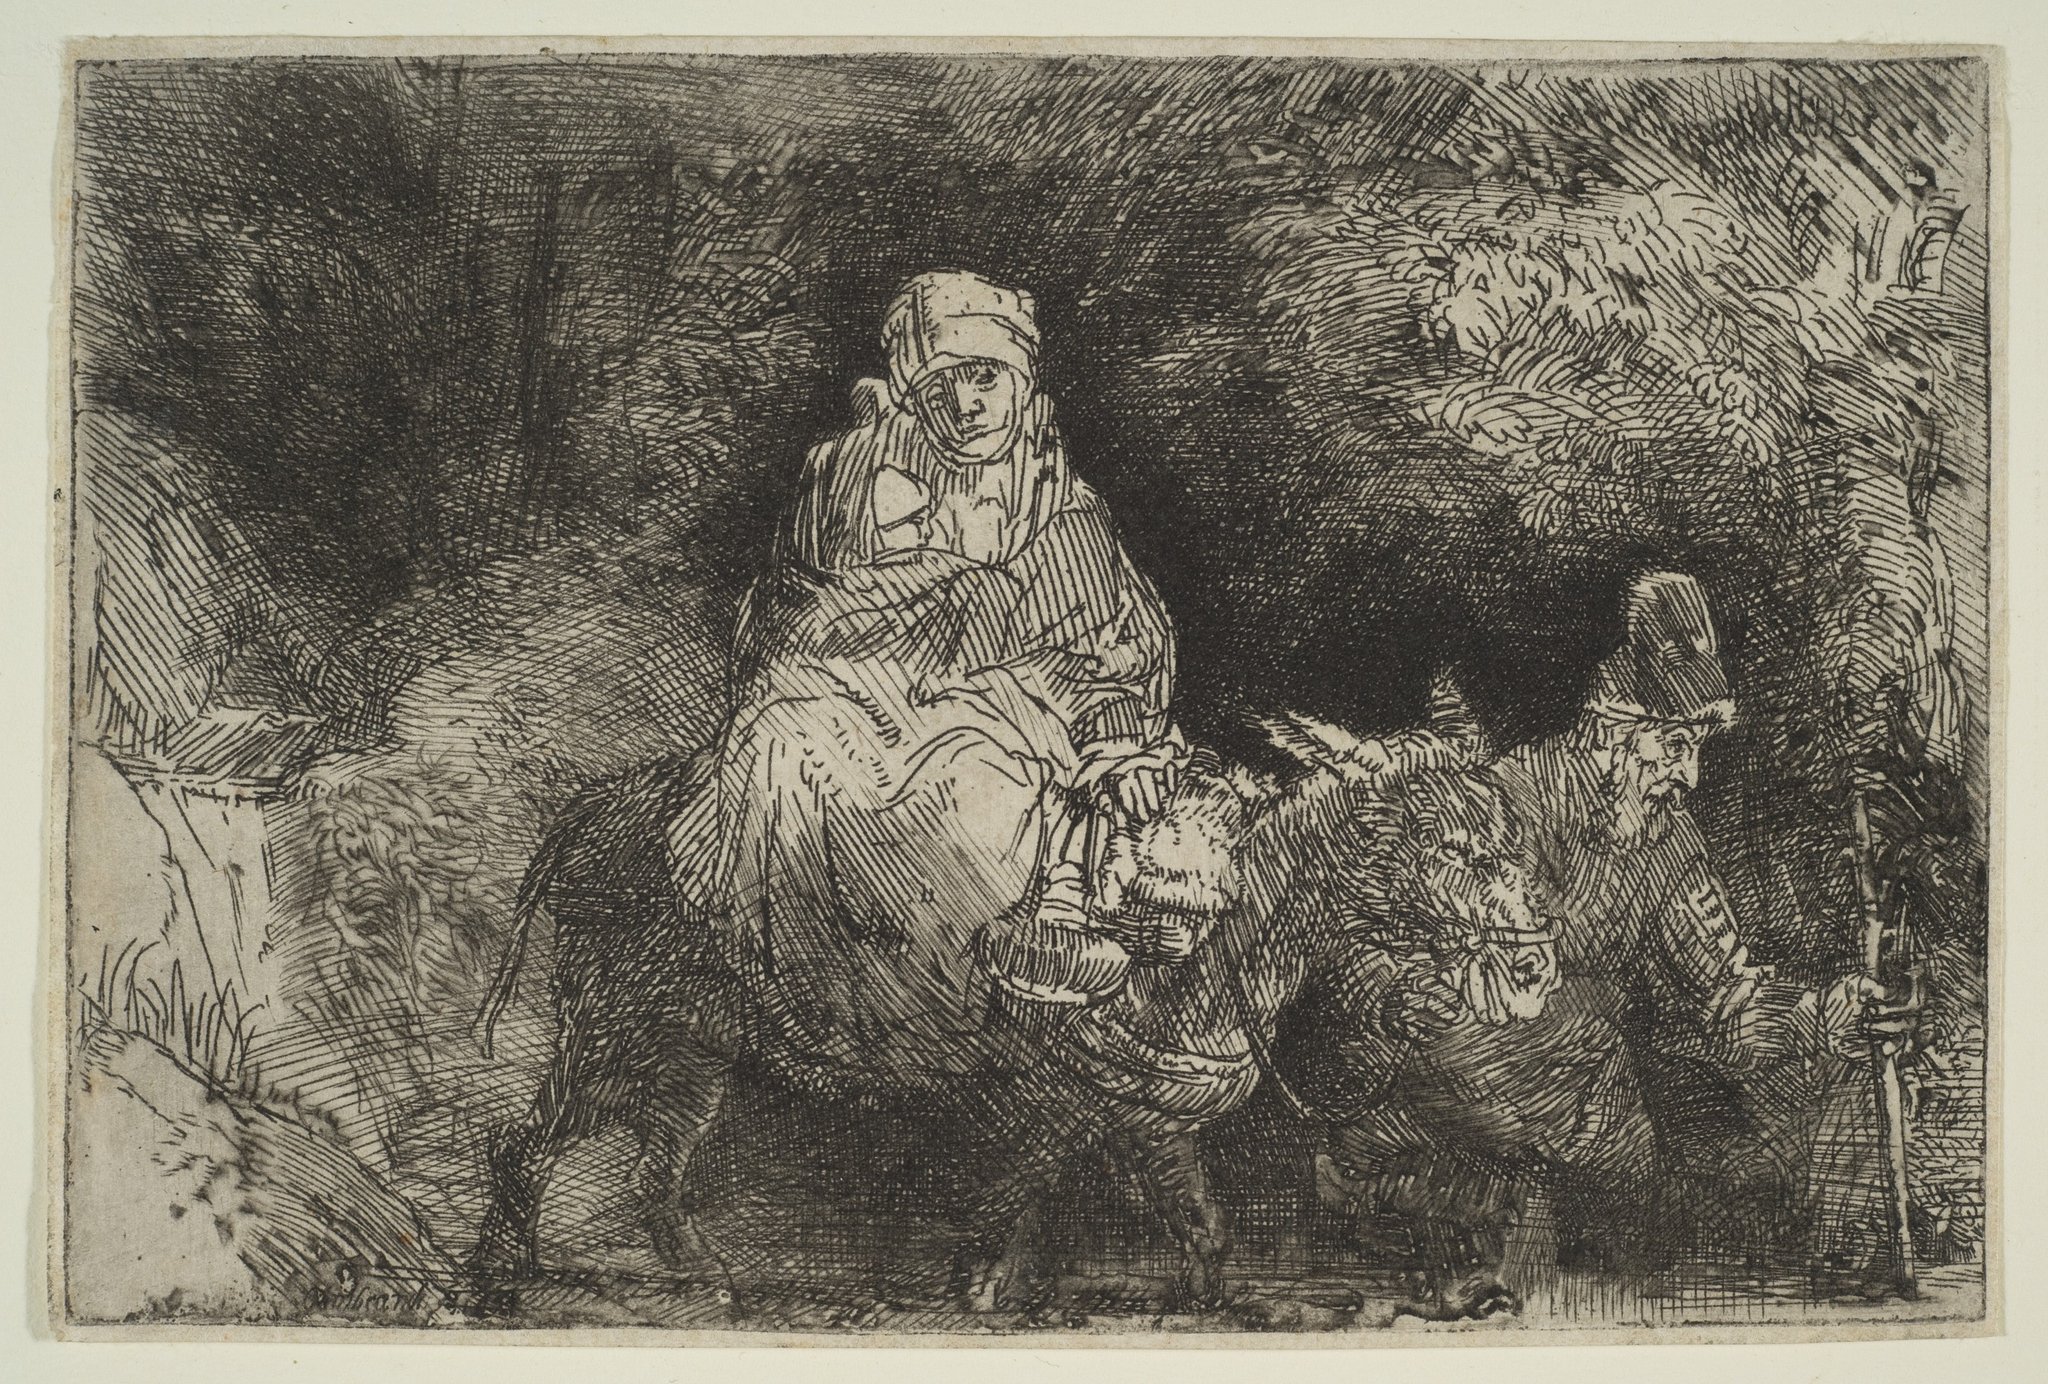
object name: print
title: The Flight into Egypt: Crossing a Brook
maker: rembrandt van rijn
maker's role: artist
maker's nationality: dutch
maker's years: 1606-1669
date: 1654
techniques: drypoint, engraving, etching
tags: donkeys,holy family,jesus,flight into egypt